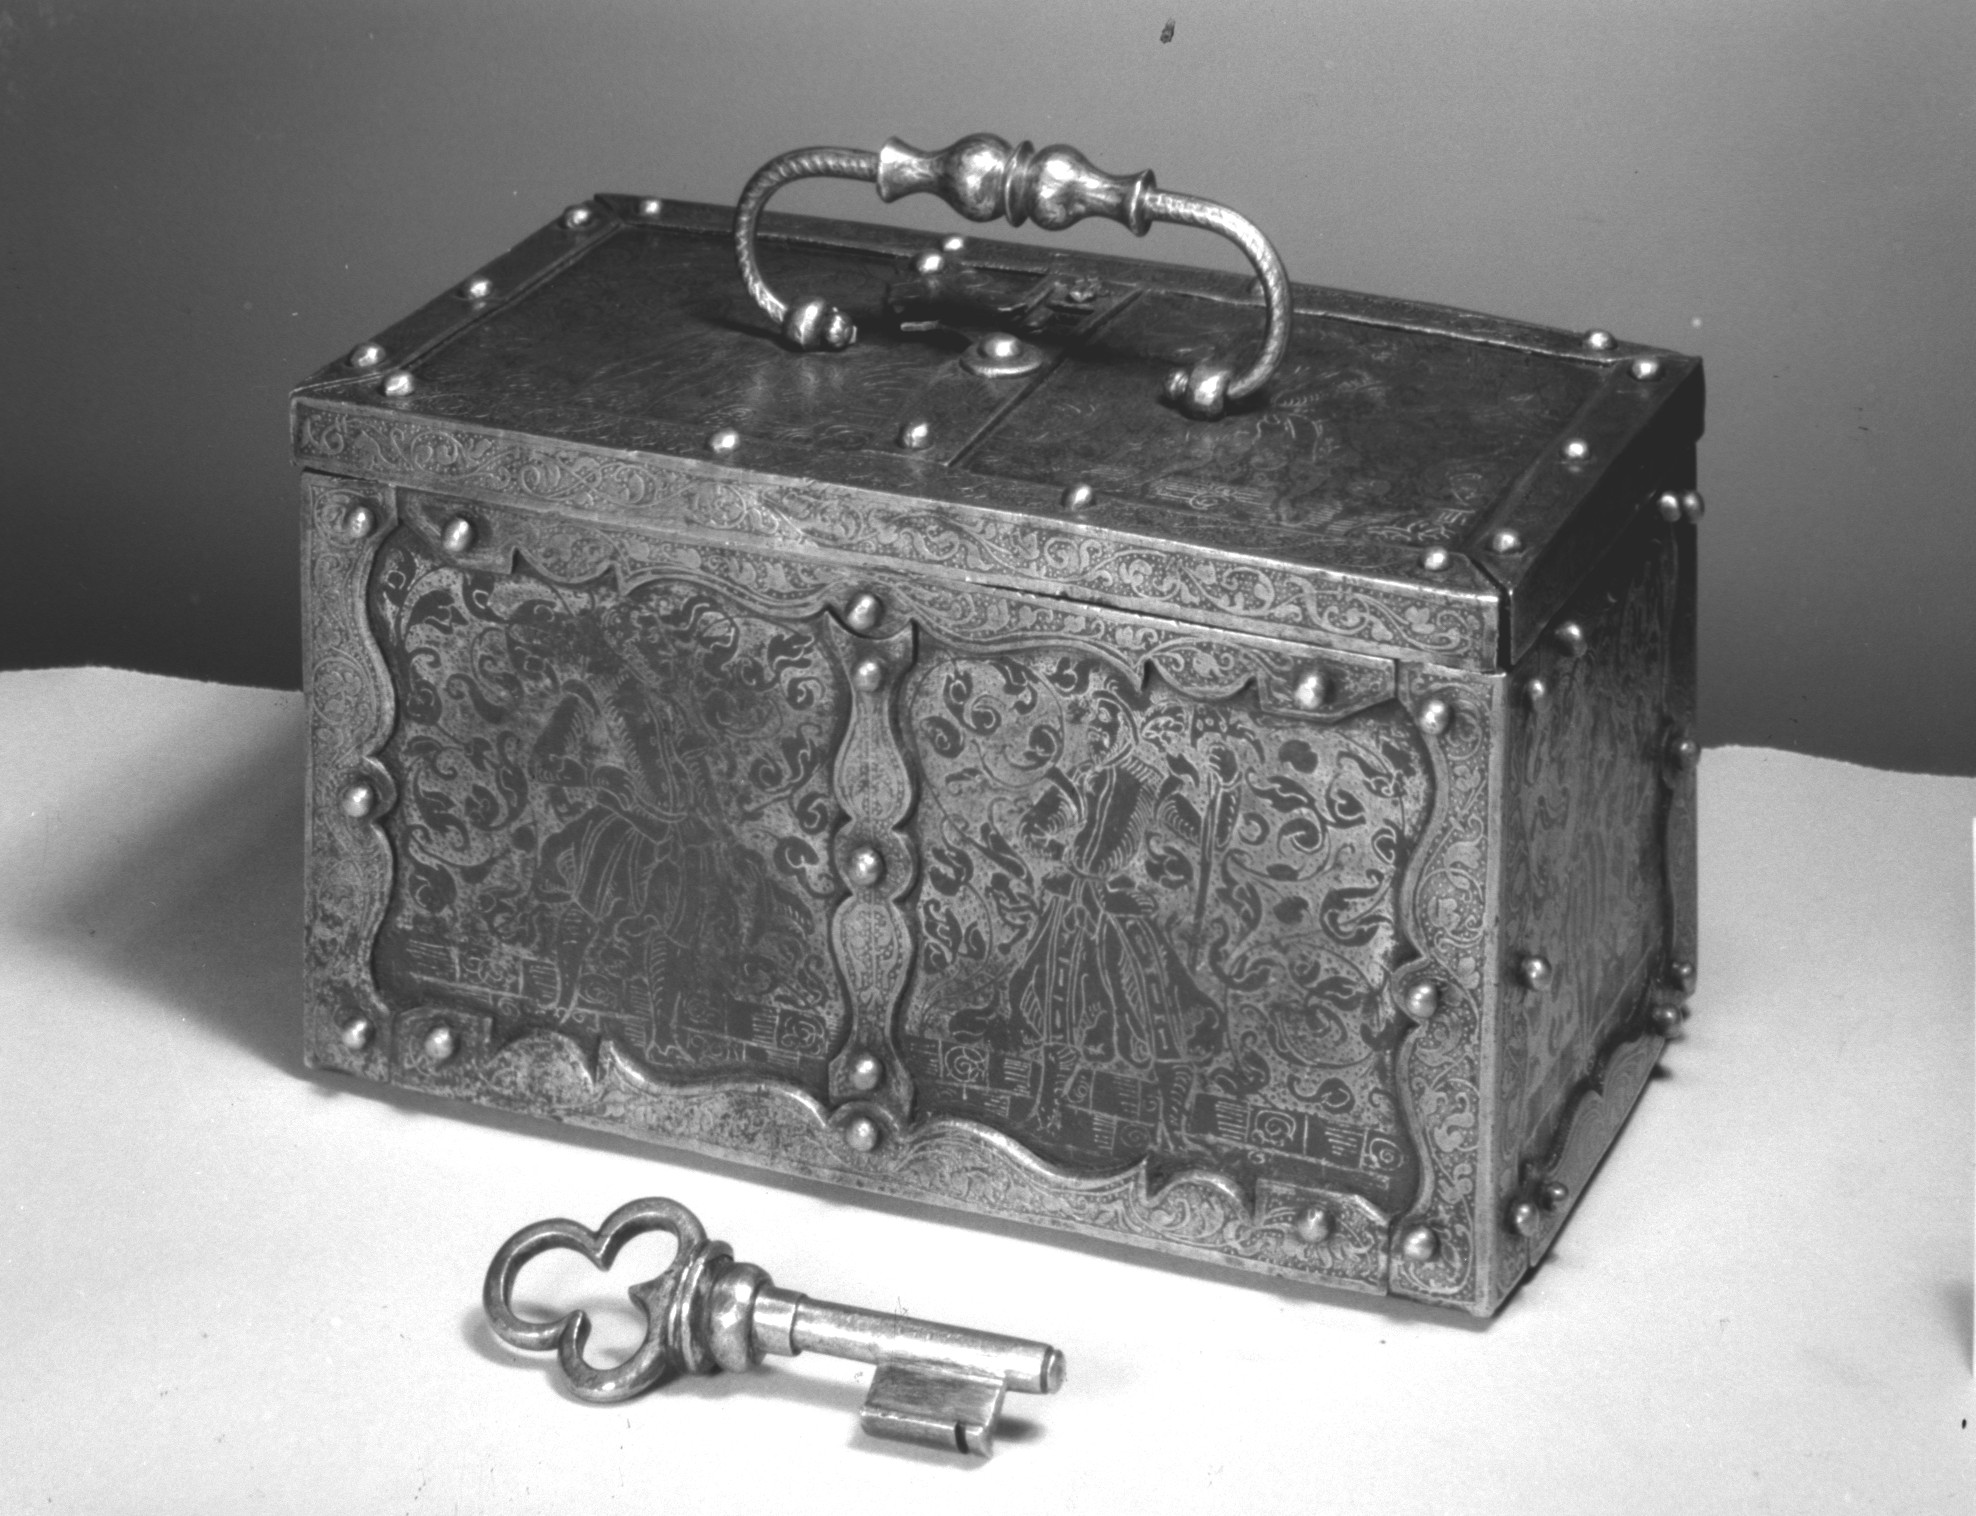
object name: box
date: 1501-1600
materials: brass, steel